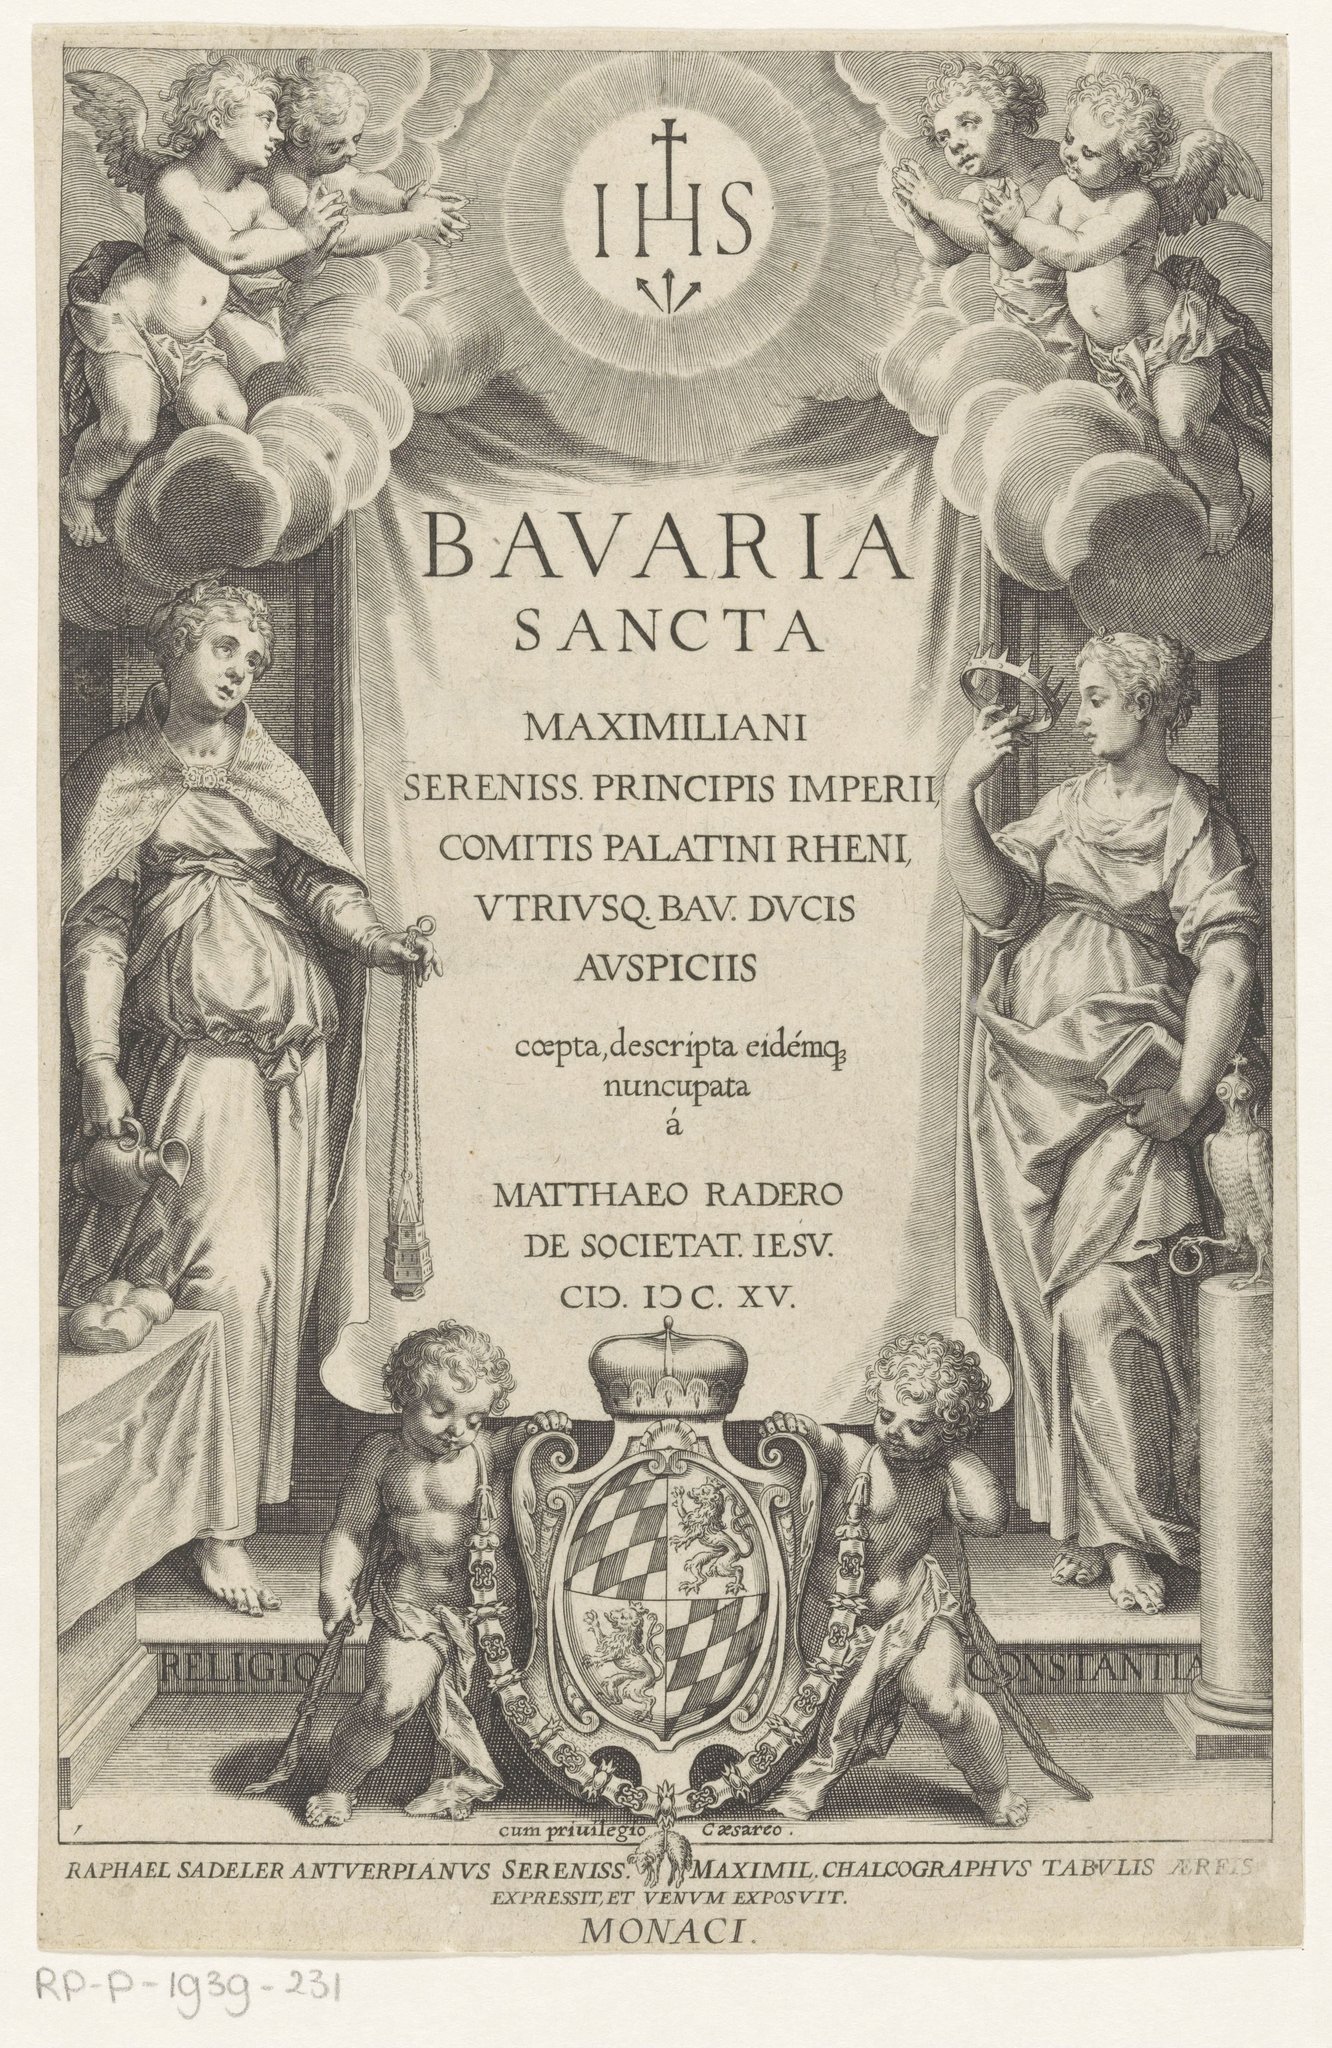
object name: print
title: Heiligen van Beieren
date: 1615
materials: paper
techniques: engraving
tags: allegorical and symbolical representations ~ the church and religion, constancy, tenacity; 'costanza', 'tenacità' (ripa)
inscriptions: collector's mark: Lugt 2228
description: In het midden de titel op een doek, geflankeerd door de personificaties Religie met wierookvat en Standvastigheid met kroon en boek. Op de voorgrond twee putti met het wapenschild van Beieren. Boven de titel het monogram van Christus (IHS) tussen vier putti.